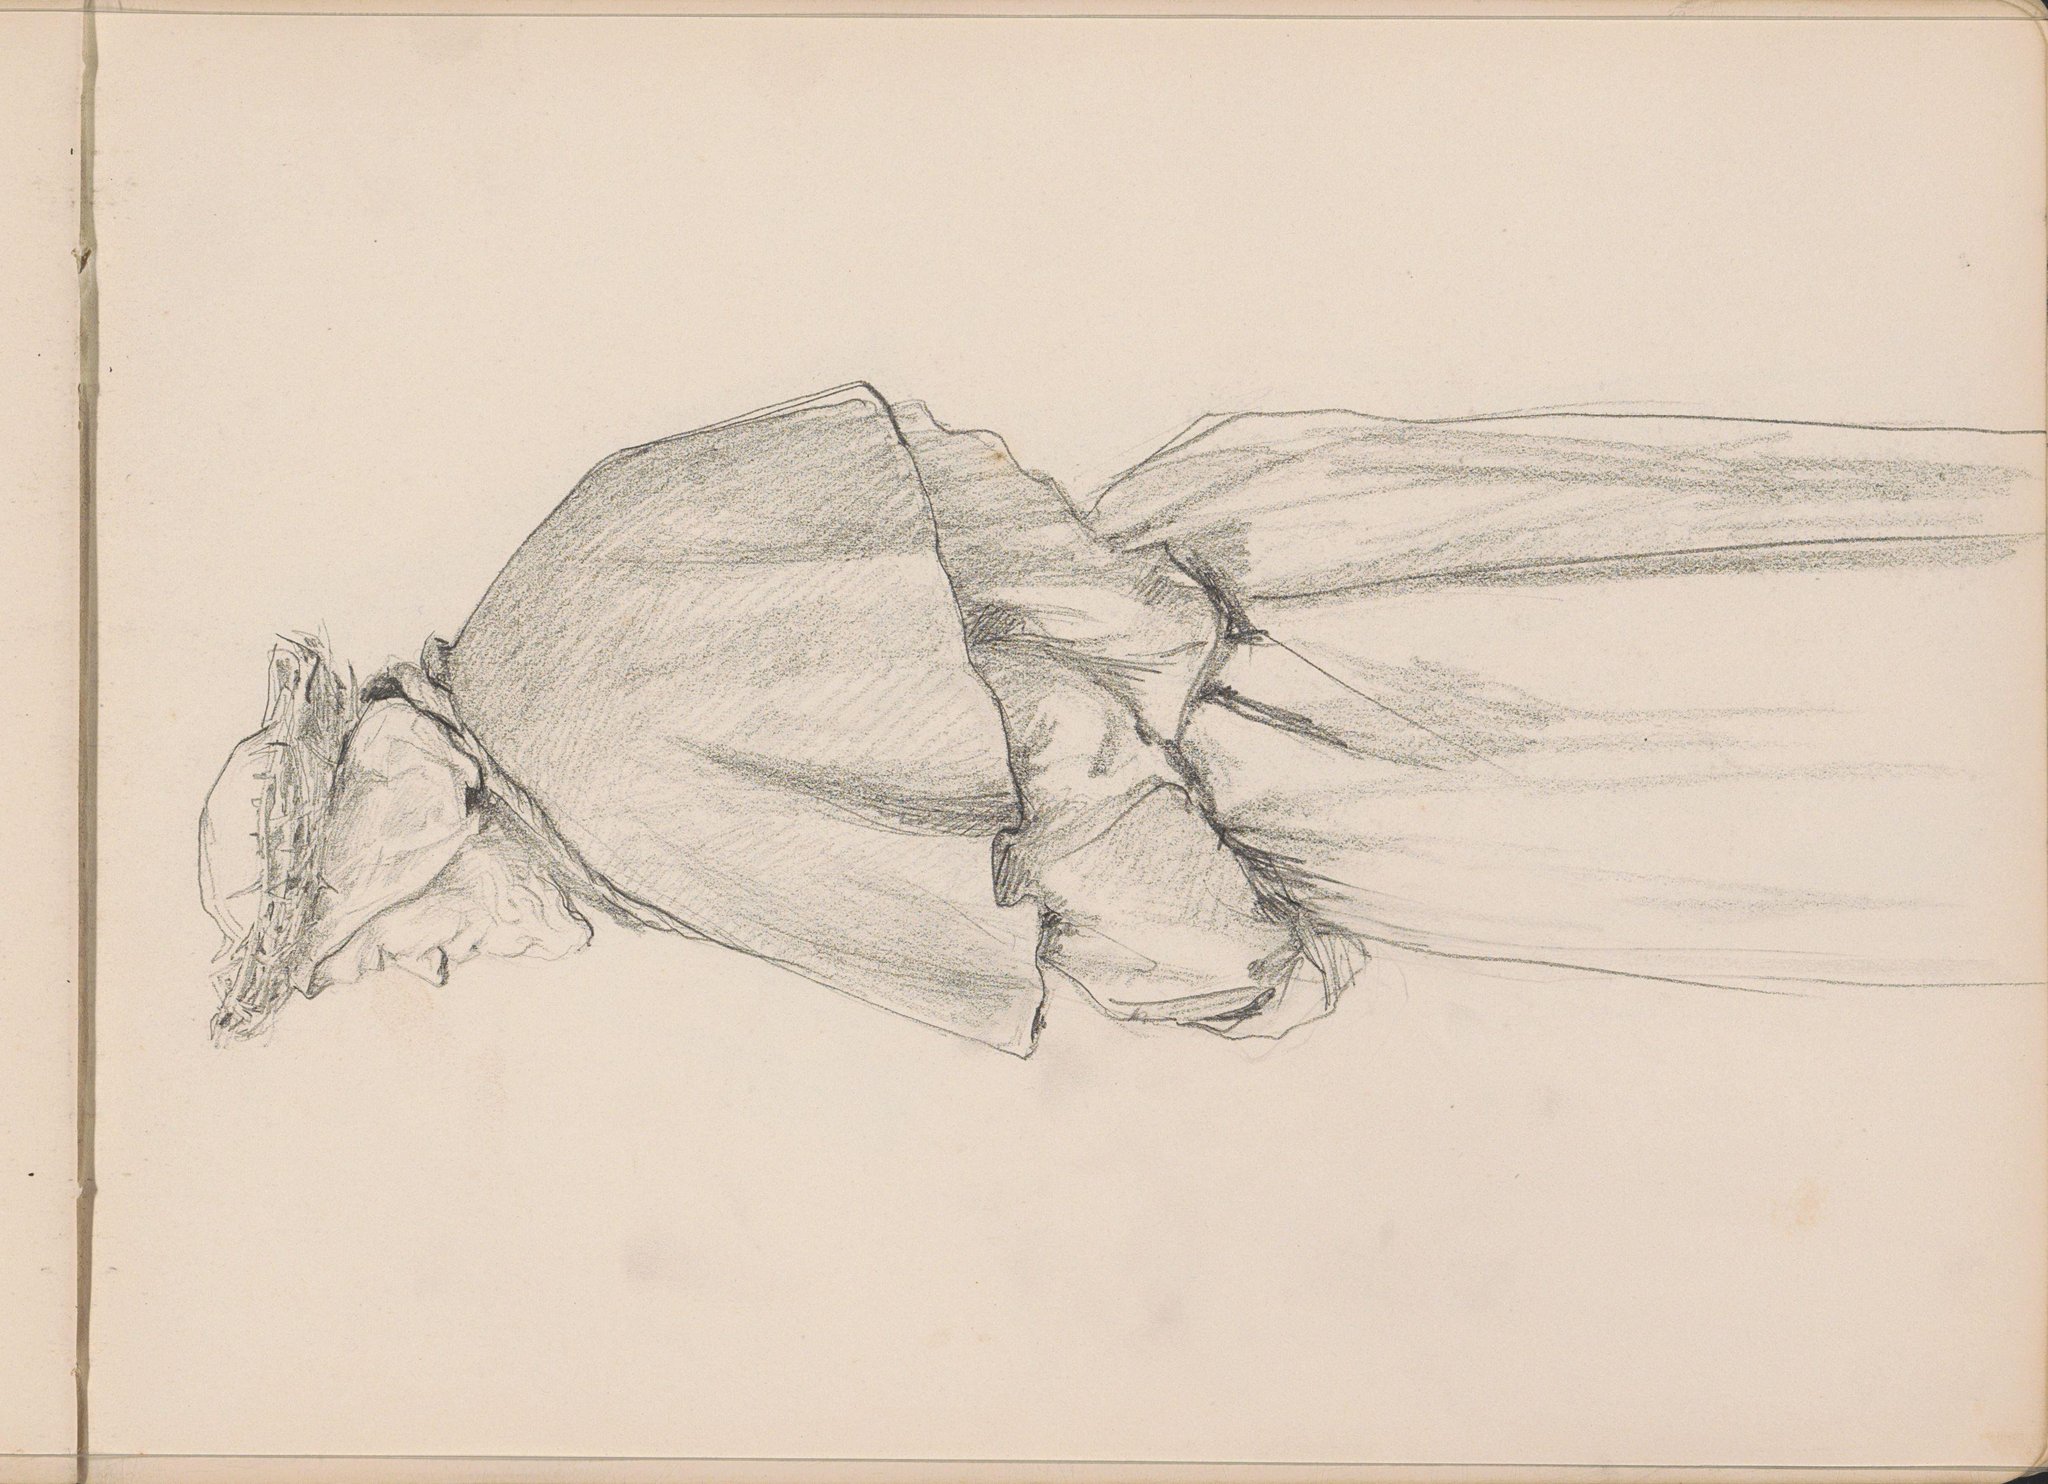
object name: sketchbook leaf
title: Monnik met een doornenkrans op het hoofd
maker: a.a.l. de grammont-hubrecht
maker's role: draughtsman, painter, print maker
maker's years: 1855-1913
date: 1865-1913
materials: paper, pencil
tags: monk(s), friar(s), crown of thorns ~ instruments of the passion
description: Blad 18 recto uit een schetsboek met 39 bladen.